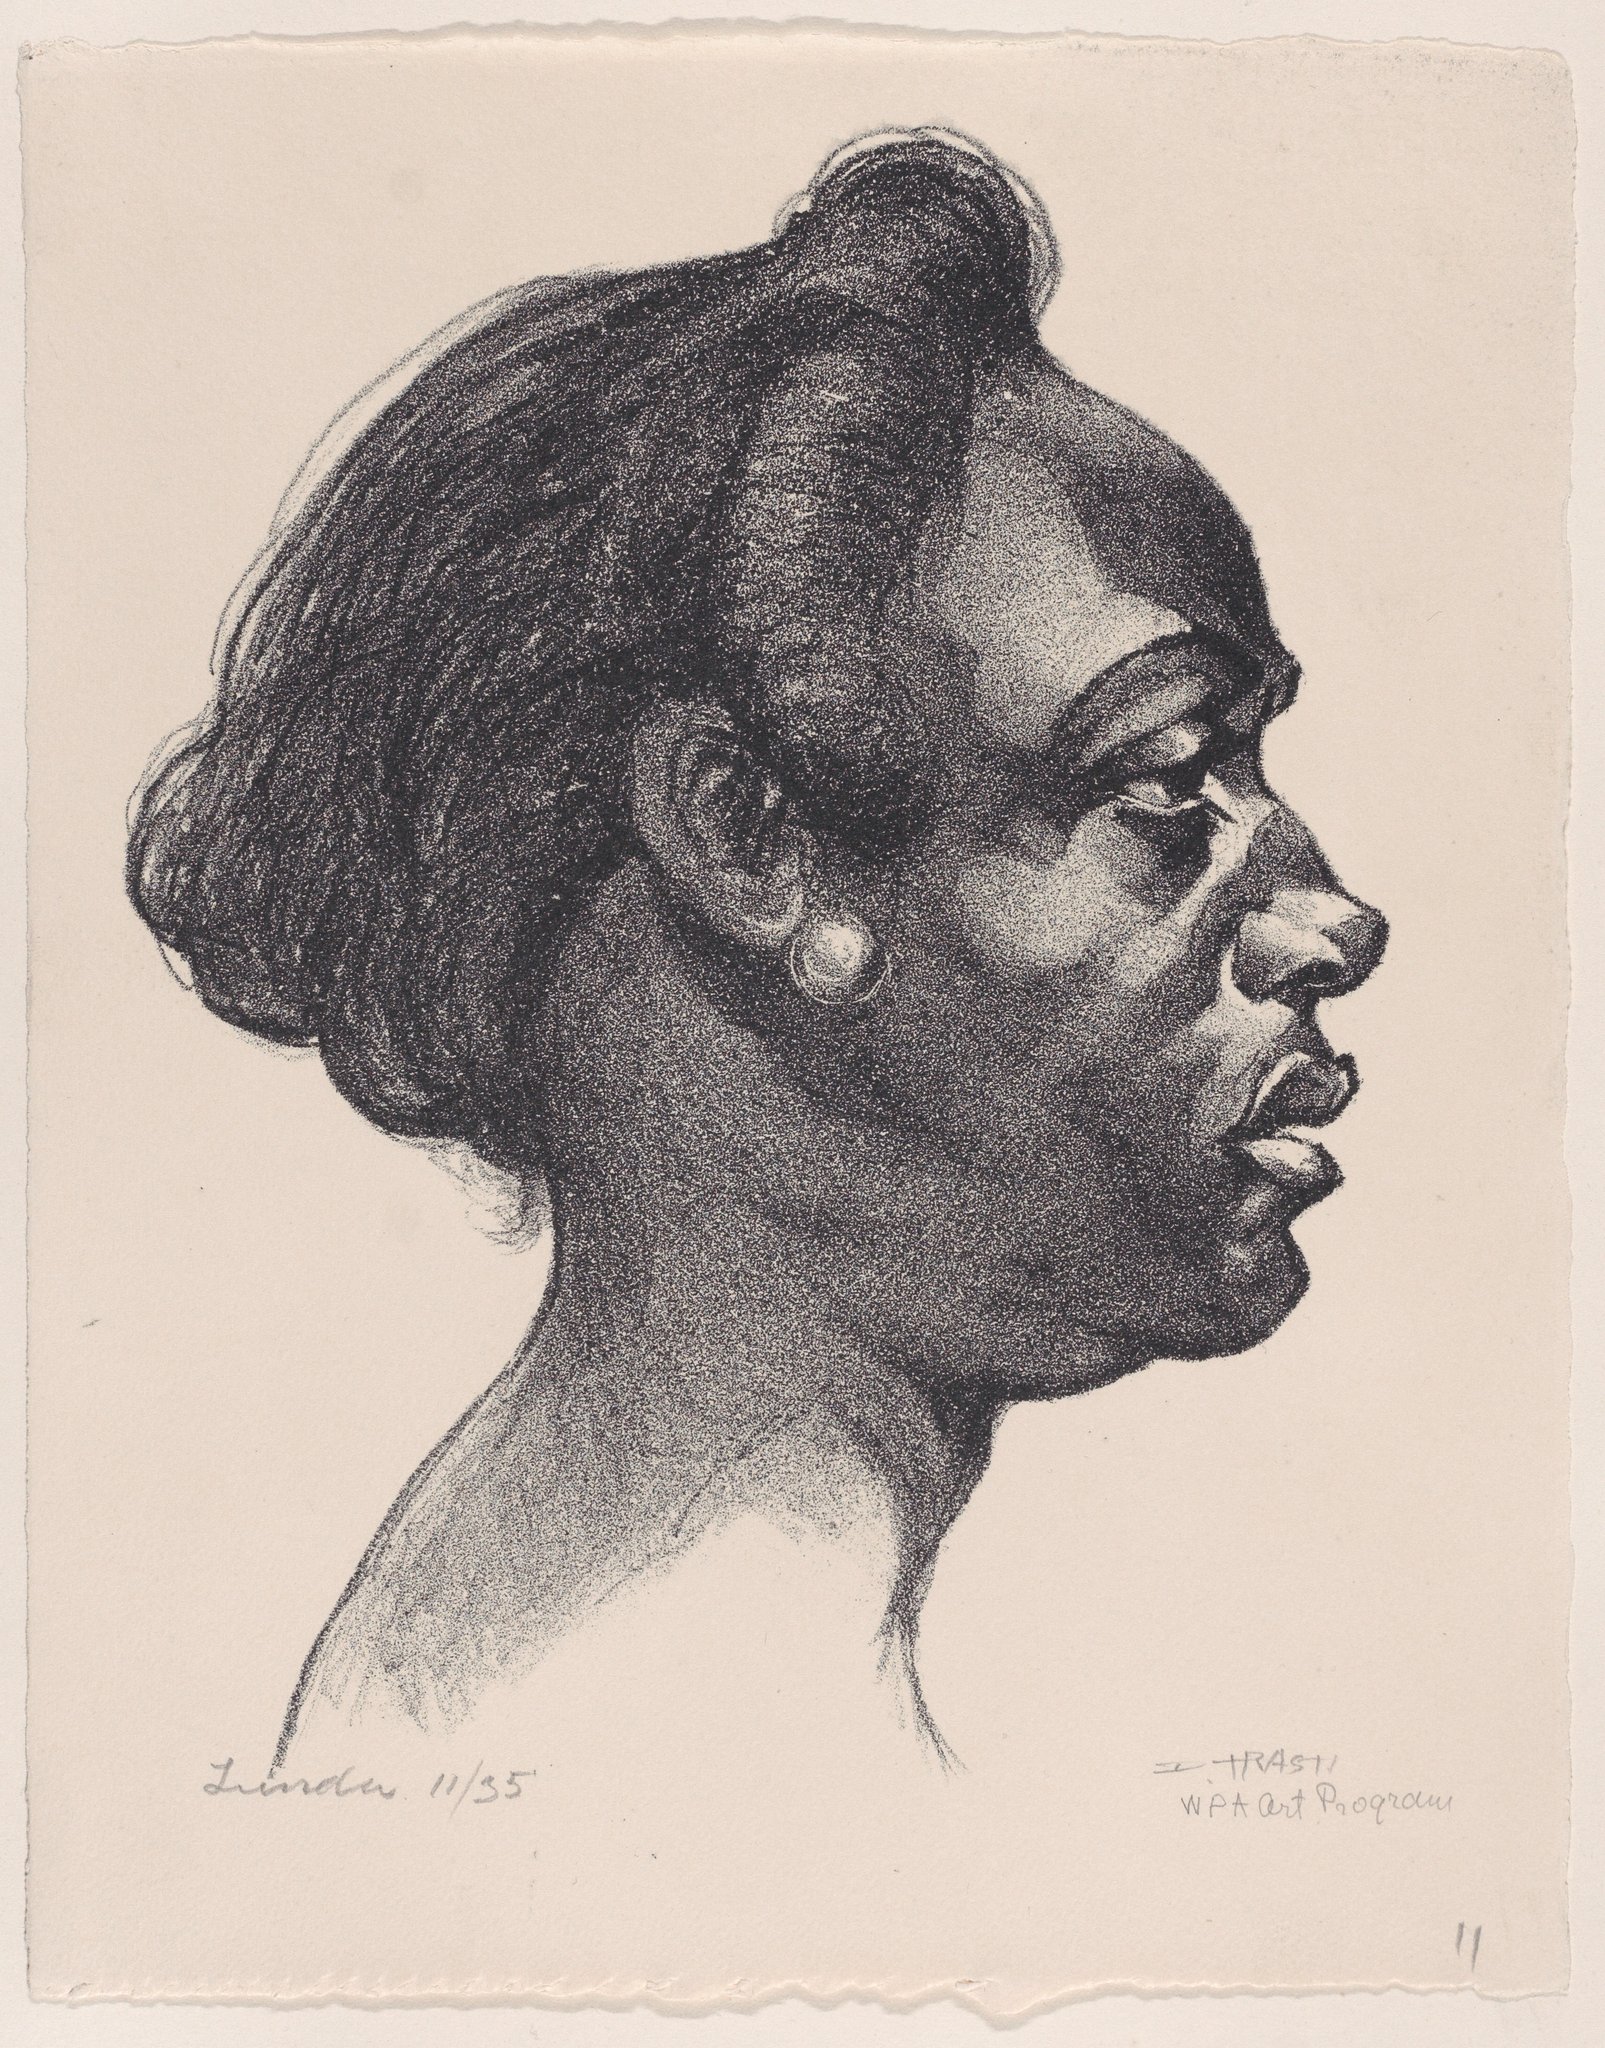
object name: print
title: Linda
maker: dox thrash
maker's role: artist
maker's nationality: american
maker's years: 1893-1965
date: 1940-1941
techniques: lithograph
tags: portraits,women